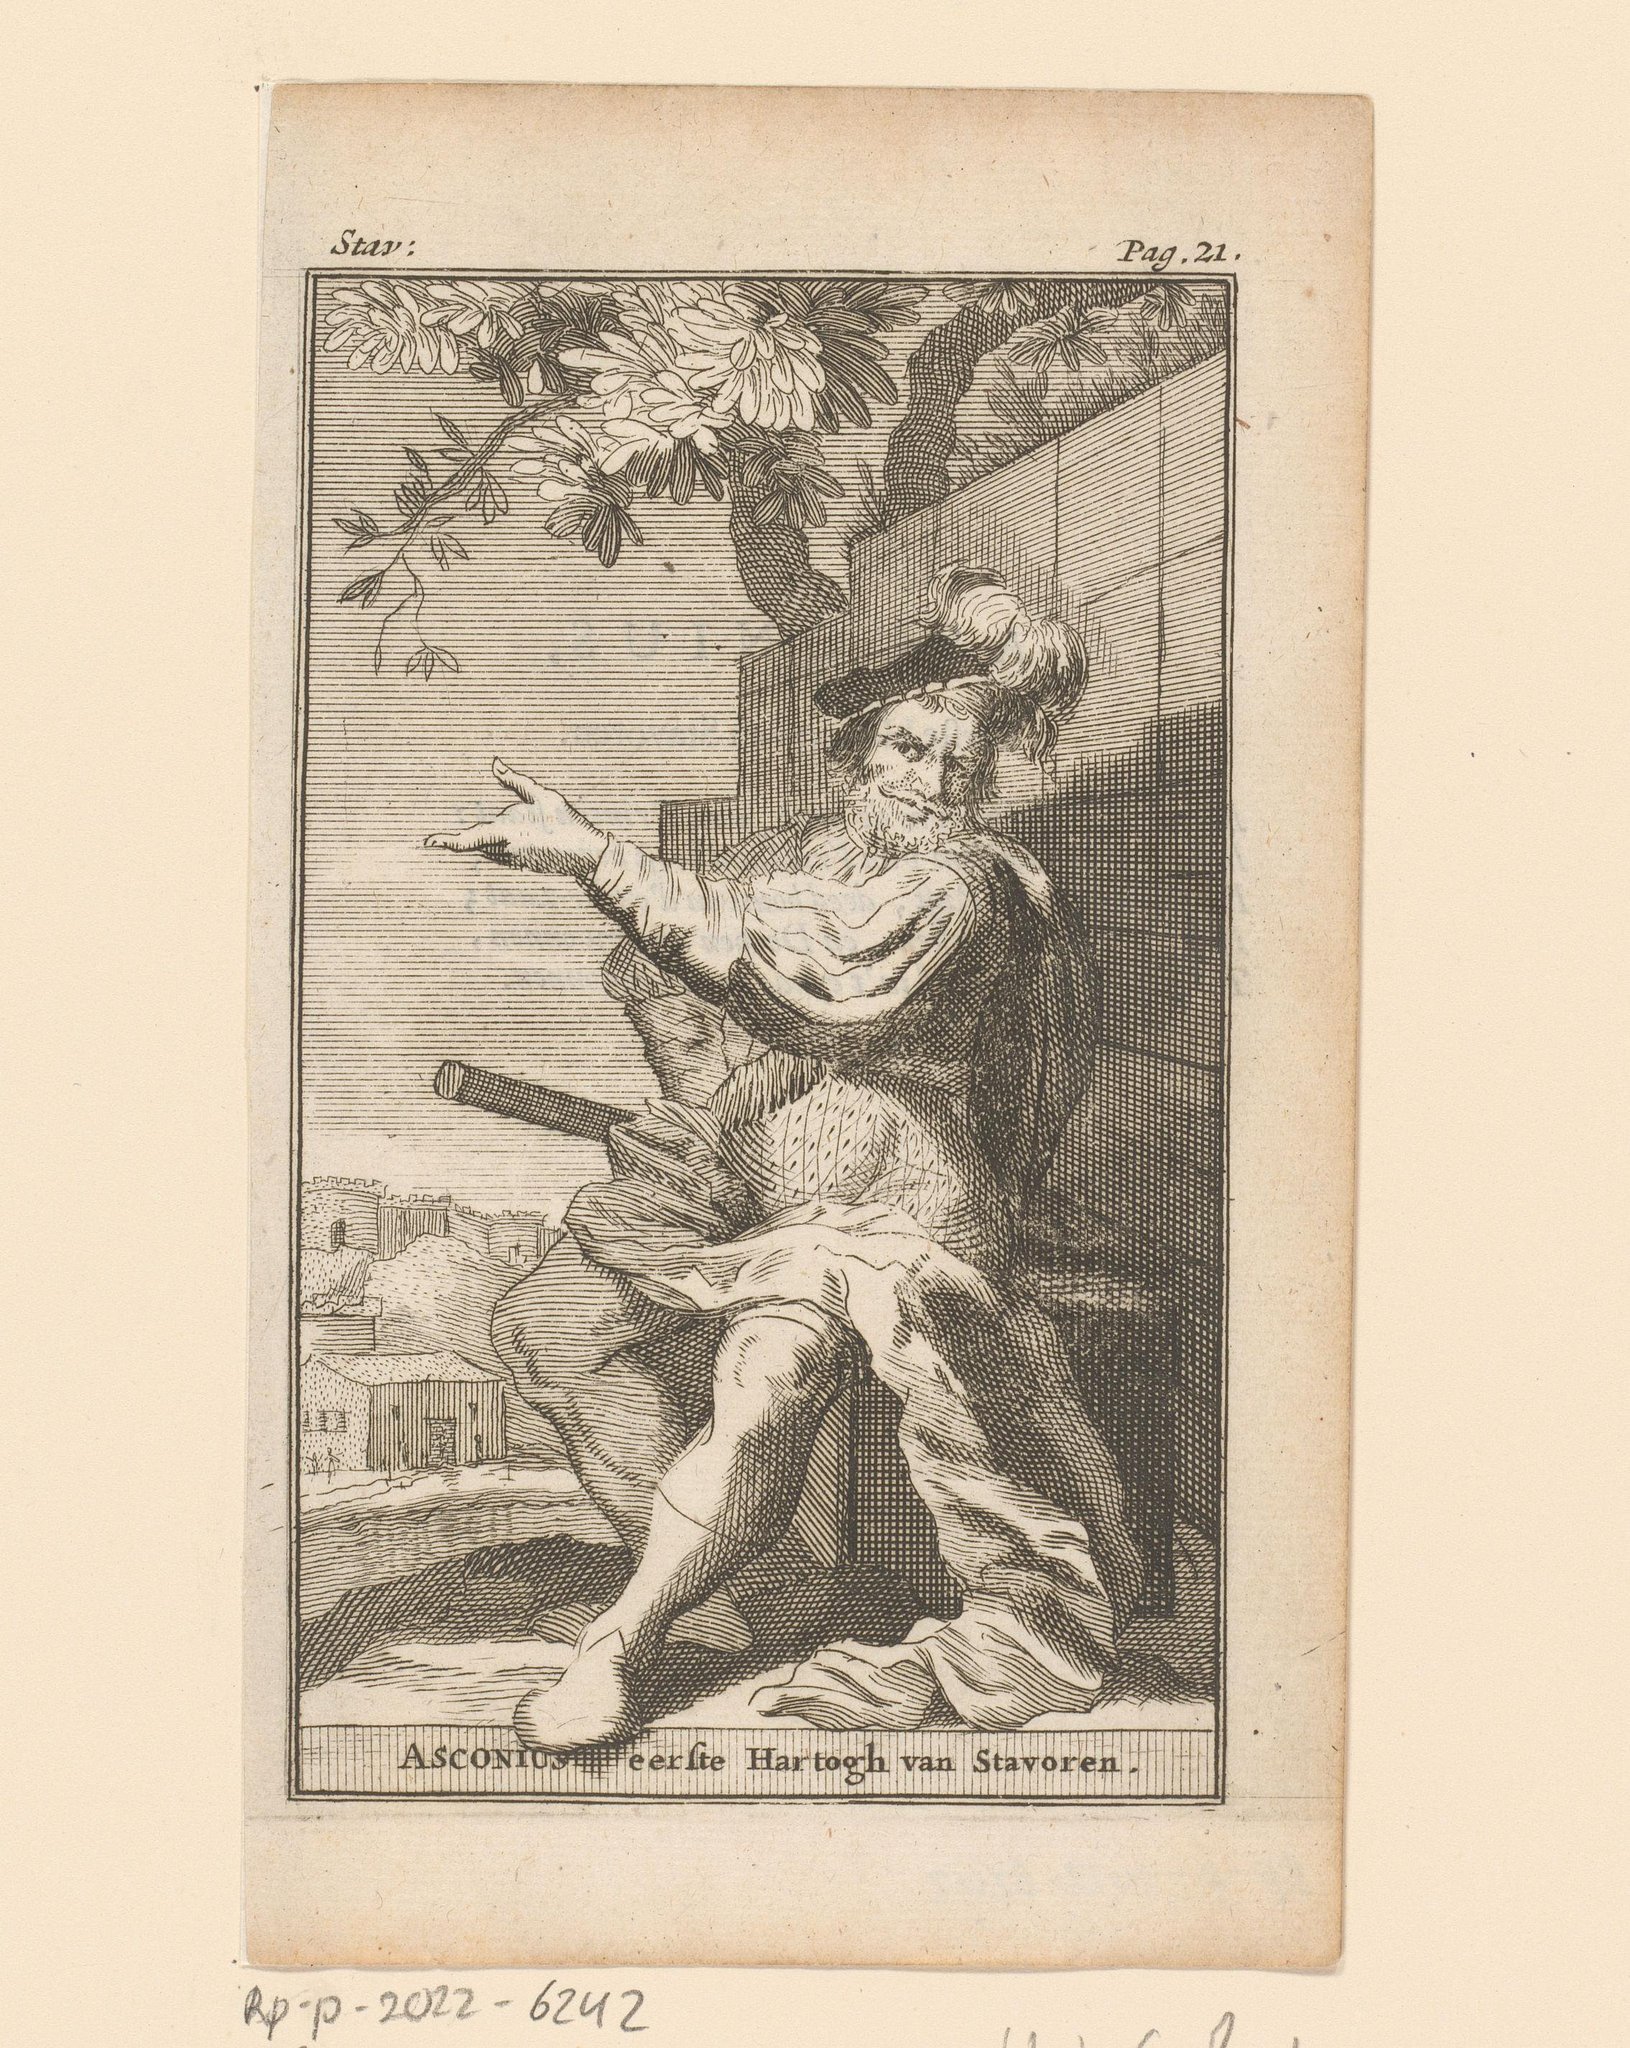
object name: print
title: Portret van Ascon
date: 1702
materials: paper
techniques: etching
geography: amsterdam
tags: historical persons, ruler, sovereign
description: Prent uit: Soeteboom, Hendrik Jacobszoon. Oudheden van Zaan-land, Stavoren, Vronen en Waterland: (...). Amsterdam: Wilhem Linnig van Koppenol, 1702.